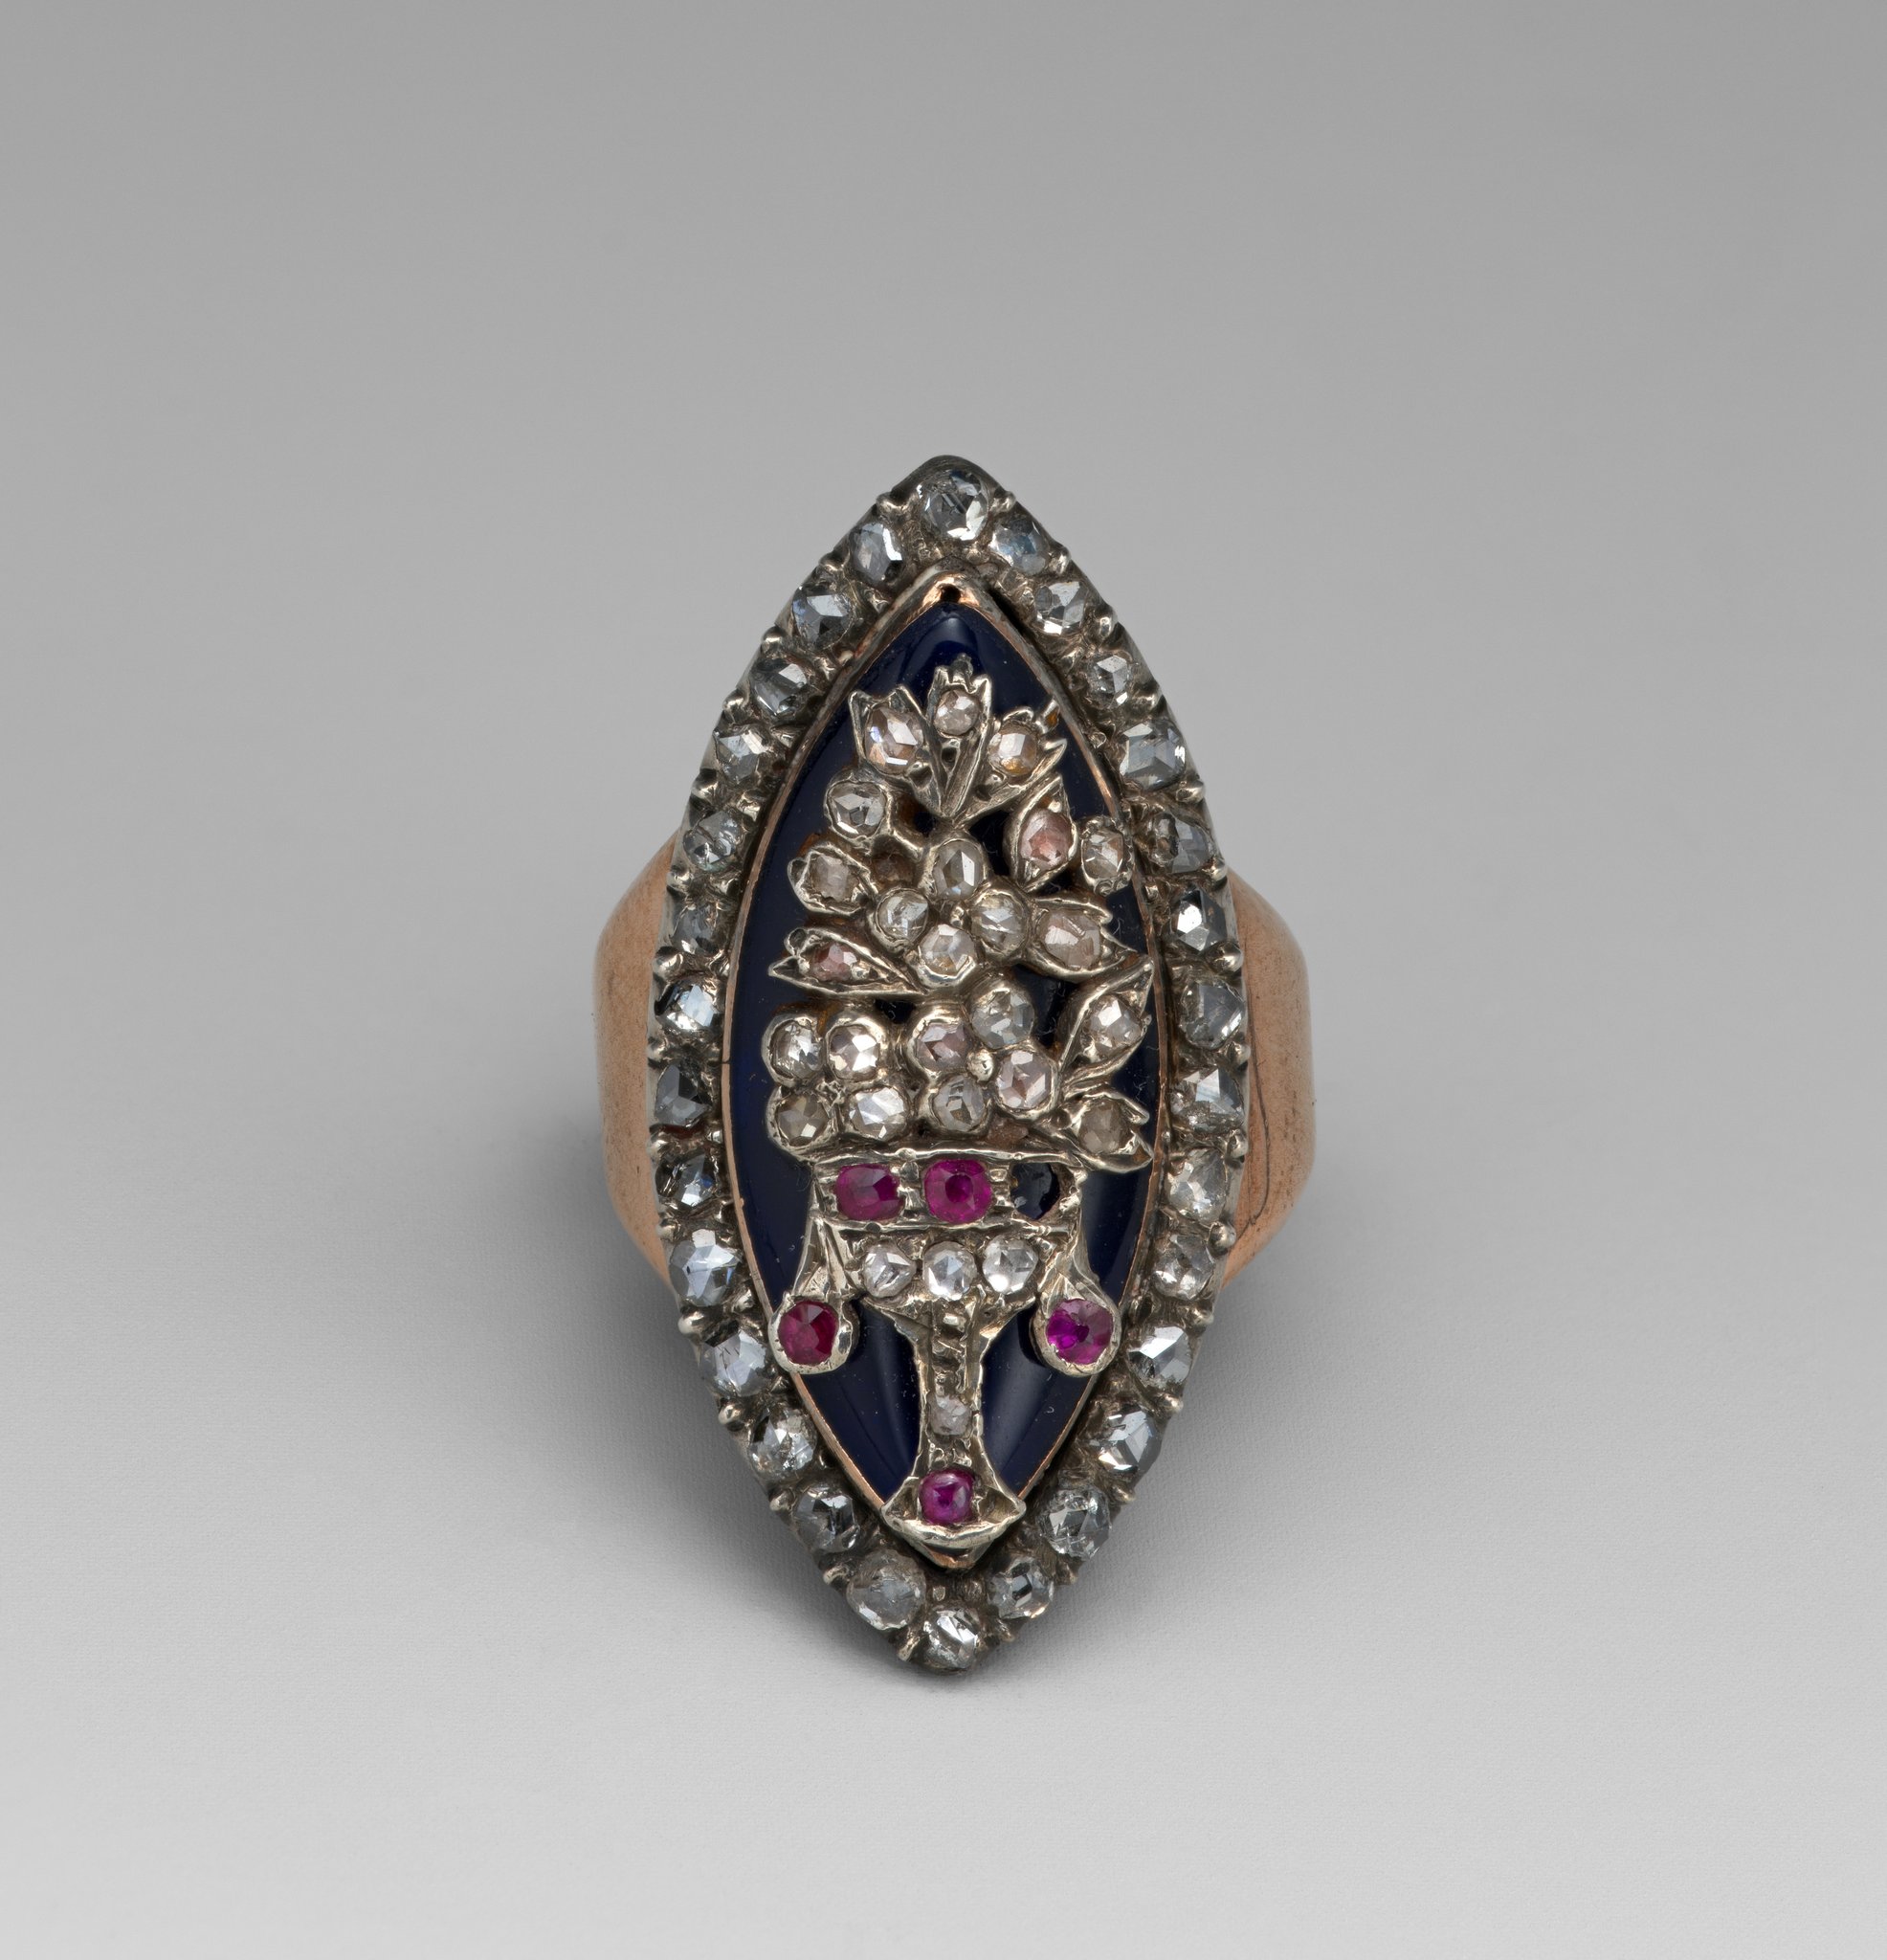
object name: ring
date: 1776-1800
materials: diamond, glass, gold, gemstone, silver